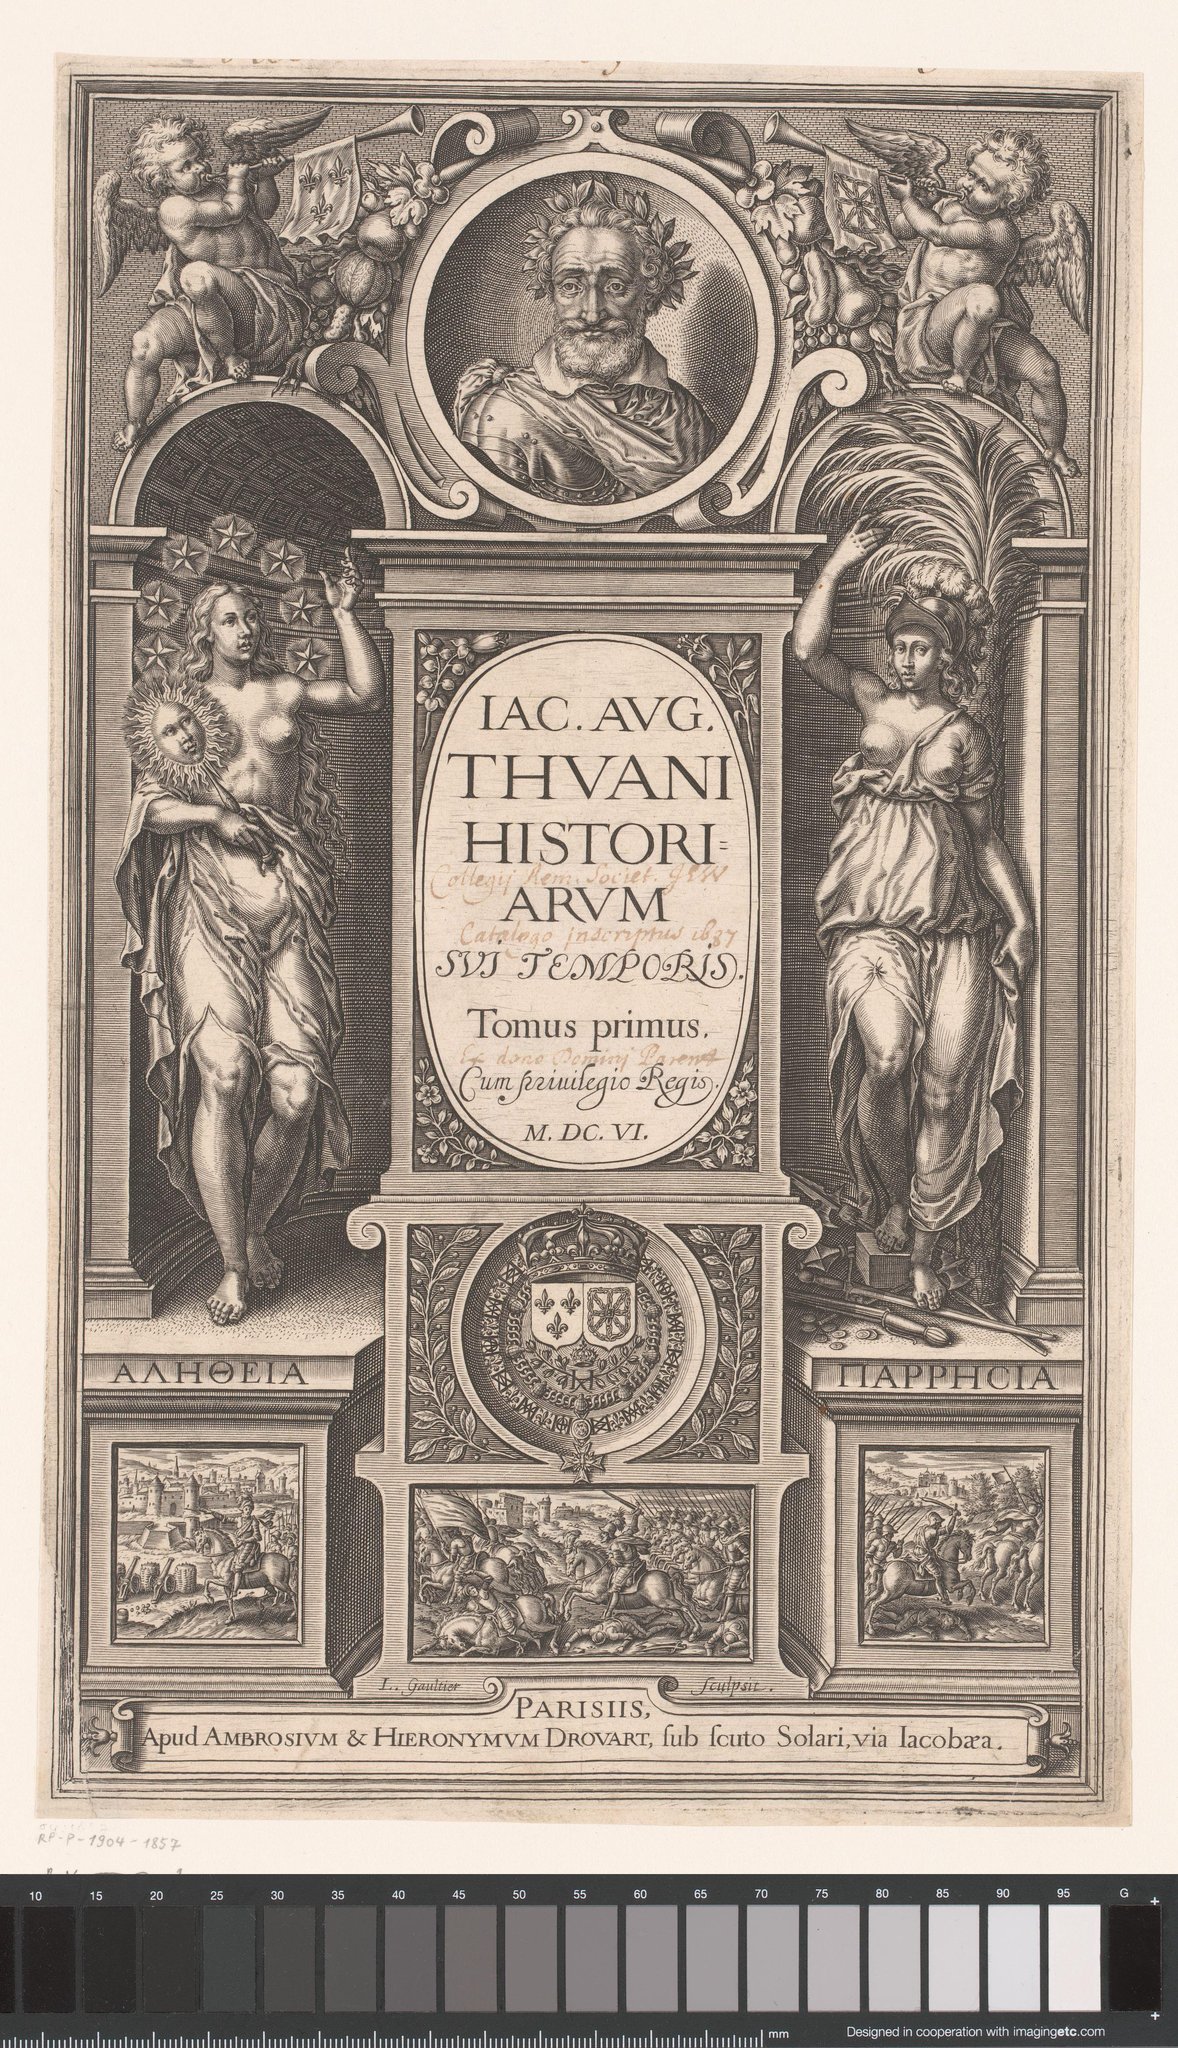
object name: print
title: Allegorische voorstelling met de Waarheid en veldslagscène in een fries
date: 1606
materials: ink, paper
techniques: engraving, pen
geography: france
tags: mouldings ~ architecture, battle, truth; 'verità' (ripa)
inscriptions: inscription: ‘Collegii Rem. Societ. JSW Catalogo inscriptus 1887 Ex dono Domini Parent’, collector's mark: Lugt 2228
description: Prent uit: Thou I, Jacques Auguste de. Thuani Historiarum Sui Temporis. Parijs: Ambrosius & Hieronymus Drouart, 1606, dl. 1.